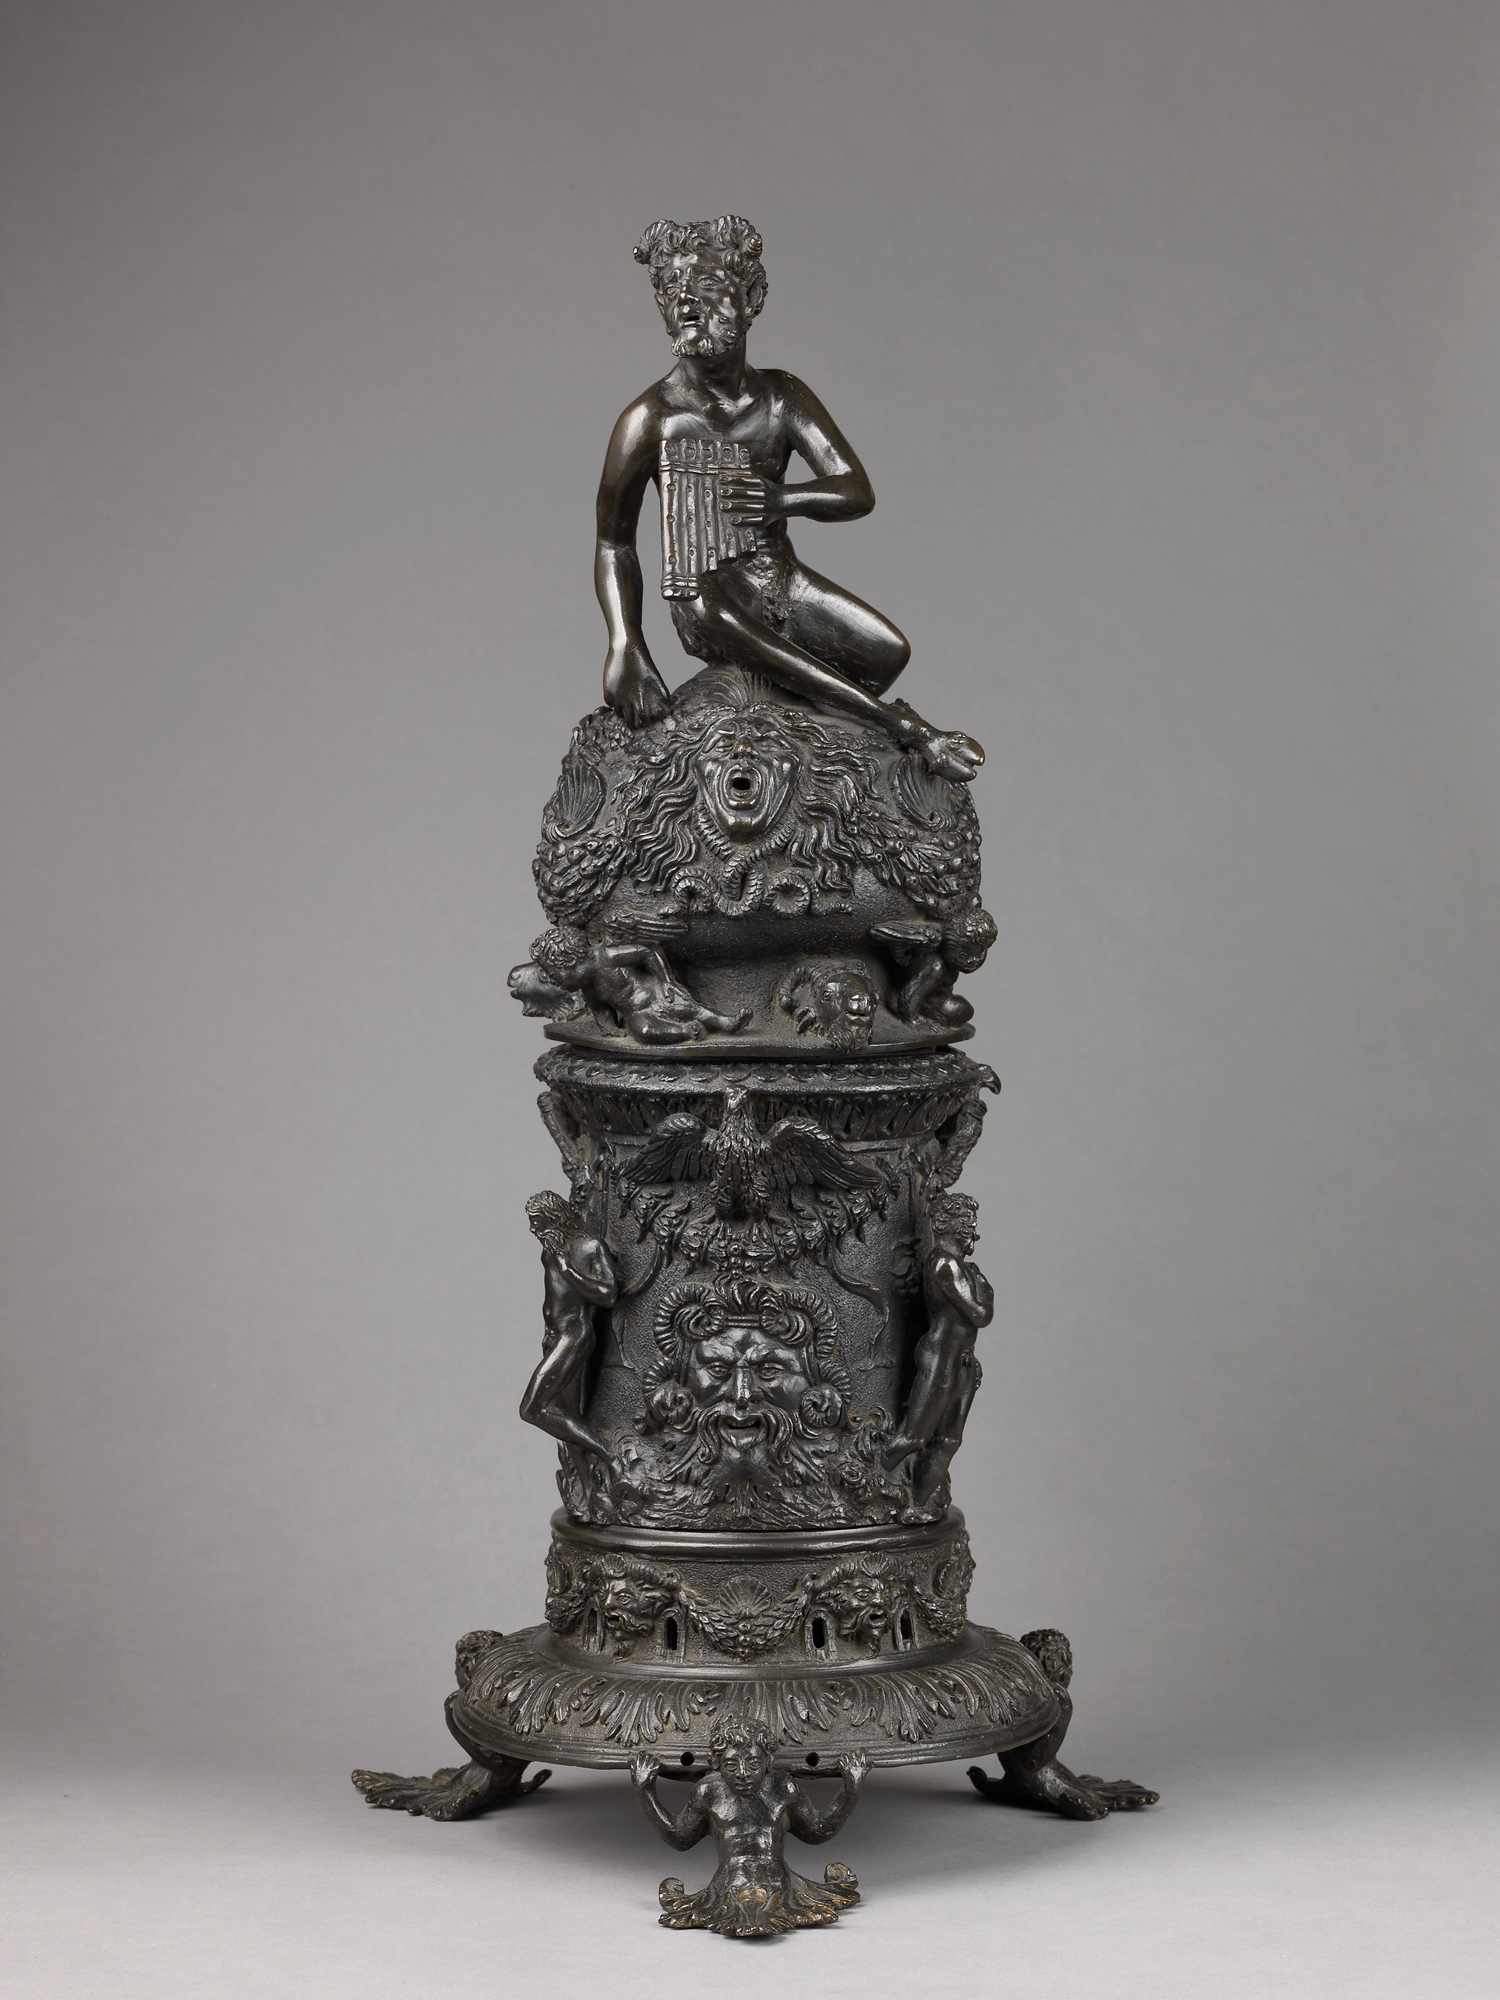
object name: incense burner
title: Perfume Burner Surmounted by a Satyr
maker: desiderio da firenze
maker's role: artist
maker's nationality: italian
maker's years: 1532-1545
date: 1530-1540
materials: alloy, patina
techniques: gilding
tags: musical instruments,eagles,satyrs